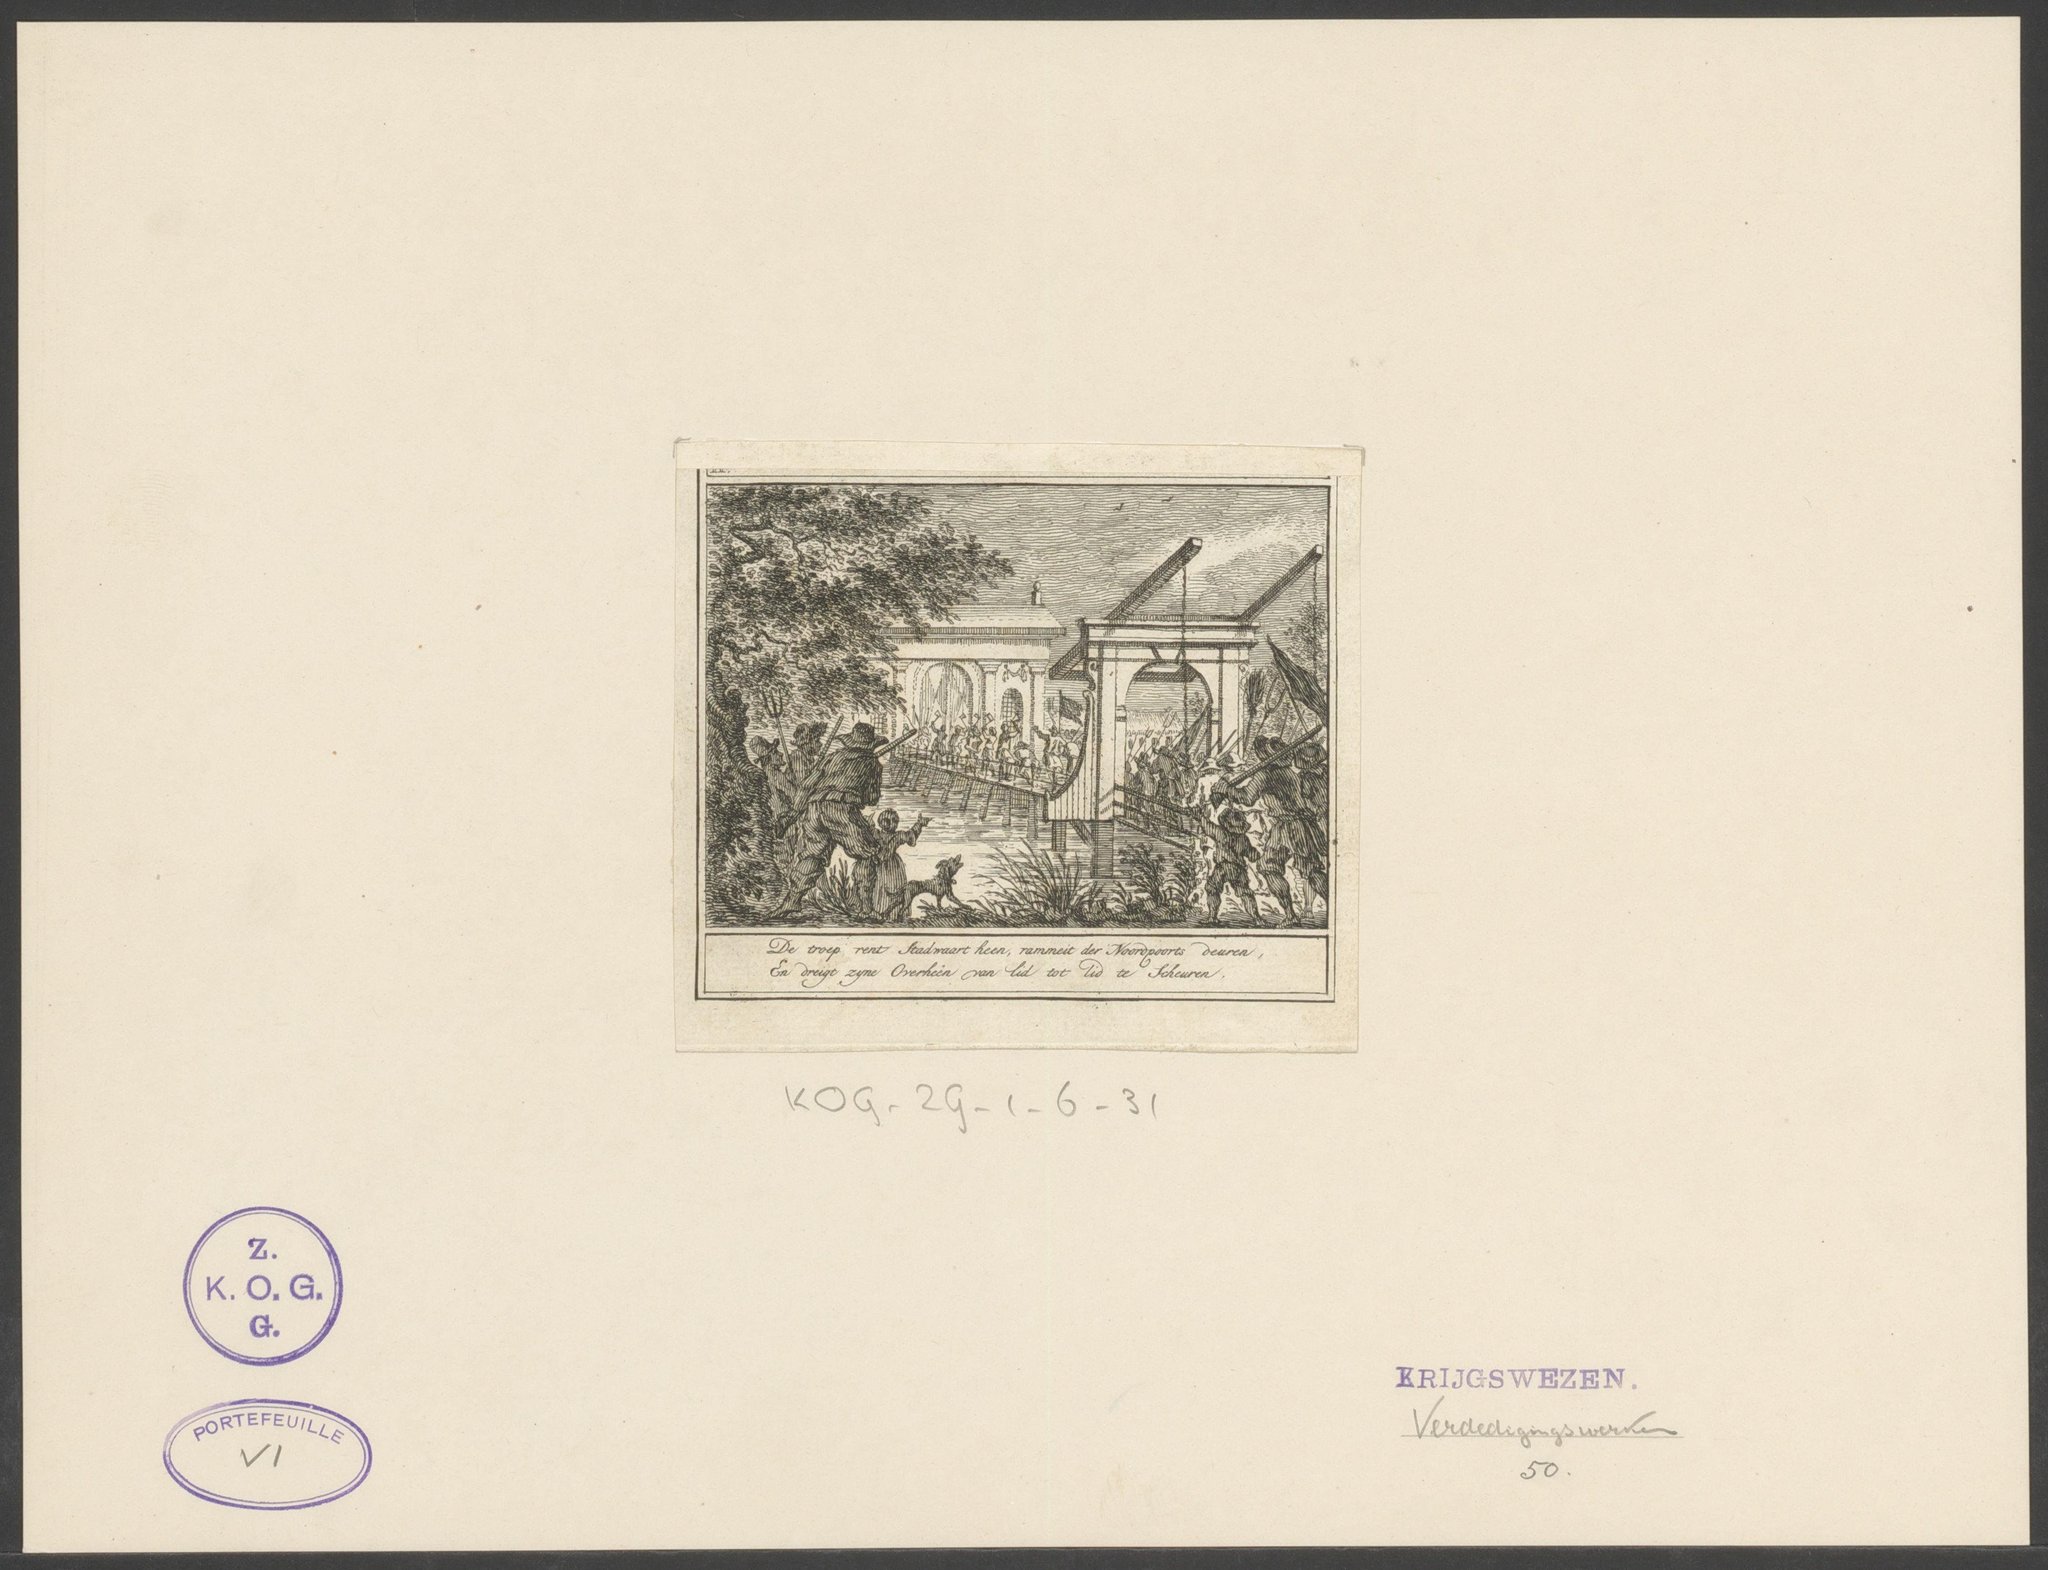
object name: print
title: Bestorming van de Noordpoort te Middelburg, 1672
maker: simon fokke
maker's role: draughtsman, print maker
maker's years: 1712-1784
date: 1764-1766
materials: paper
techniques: engraving, etching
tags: mayor, assault ~ siege, bridge, middelburg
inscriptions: collector's mark: Lugt 1641, stamp, stamp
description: Bestorming van de Noordpoort te Middelburg door de opstandige boeren, 1672. Met onderschrift van twee regels. Illustratie nr. III bij een gedicht van Petrus Johannes Beronicius over de opstandige Zeeuwse boeren en het tumult te Middelburg rond burgemeester Filips van den Brande op 21 juli 1672. Onderwerpsrubrieken binnen de Atlas Zeden en Gewoonten: Krijgswezen, Verdedigingswerken.